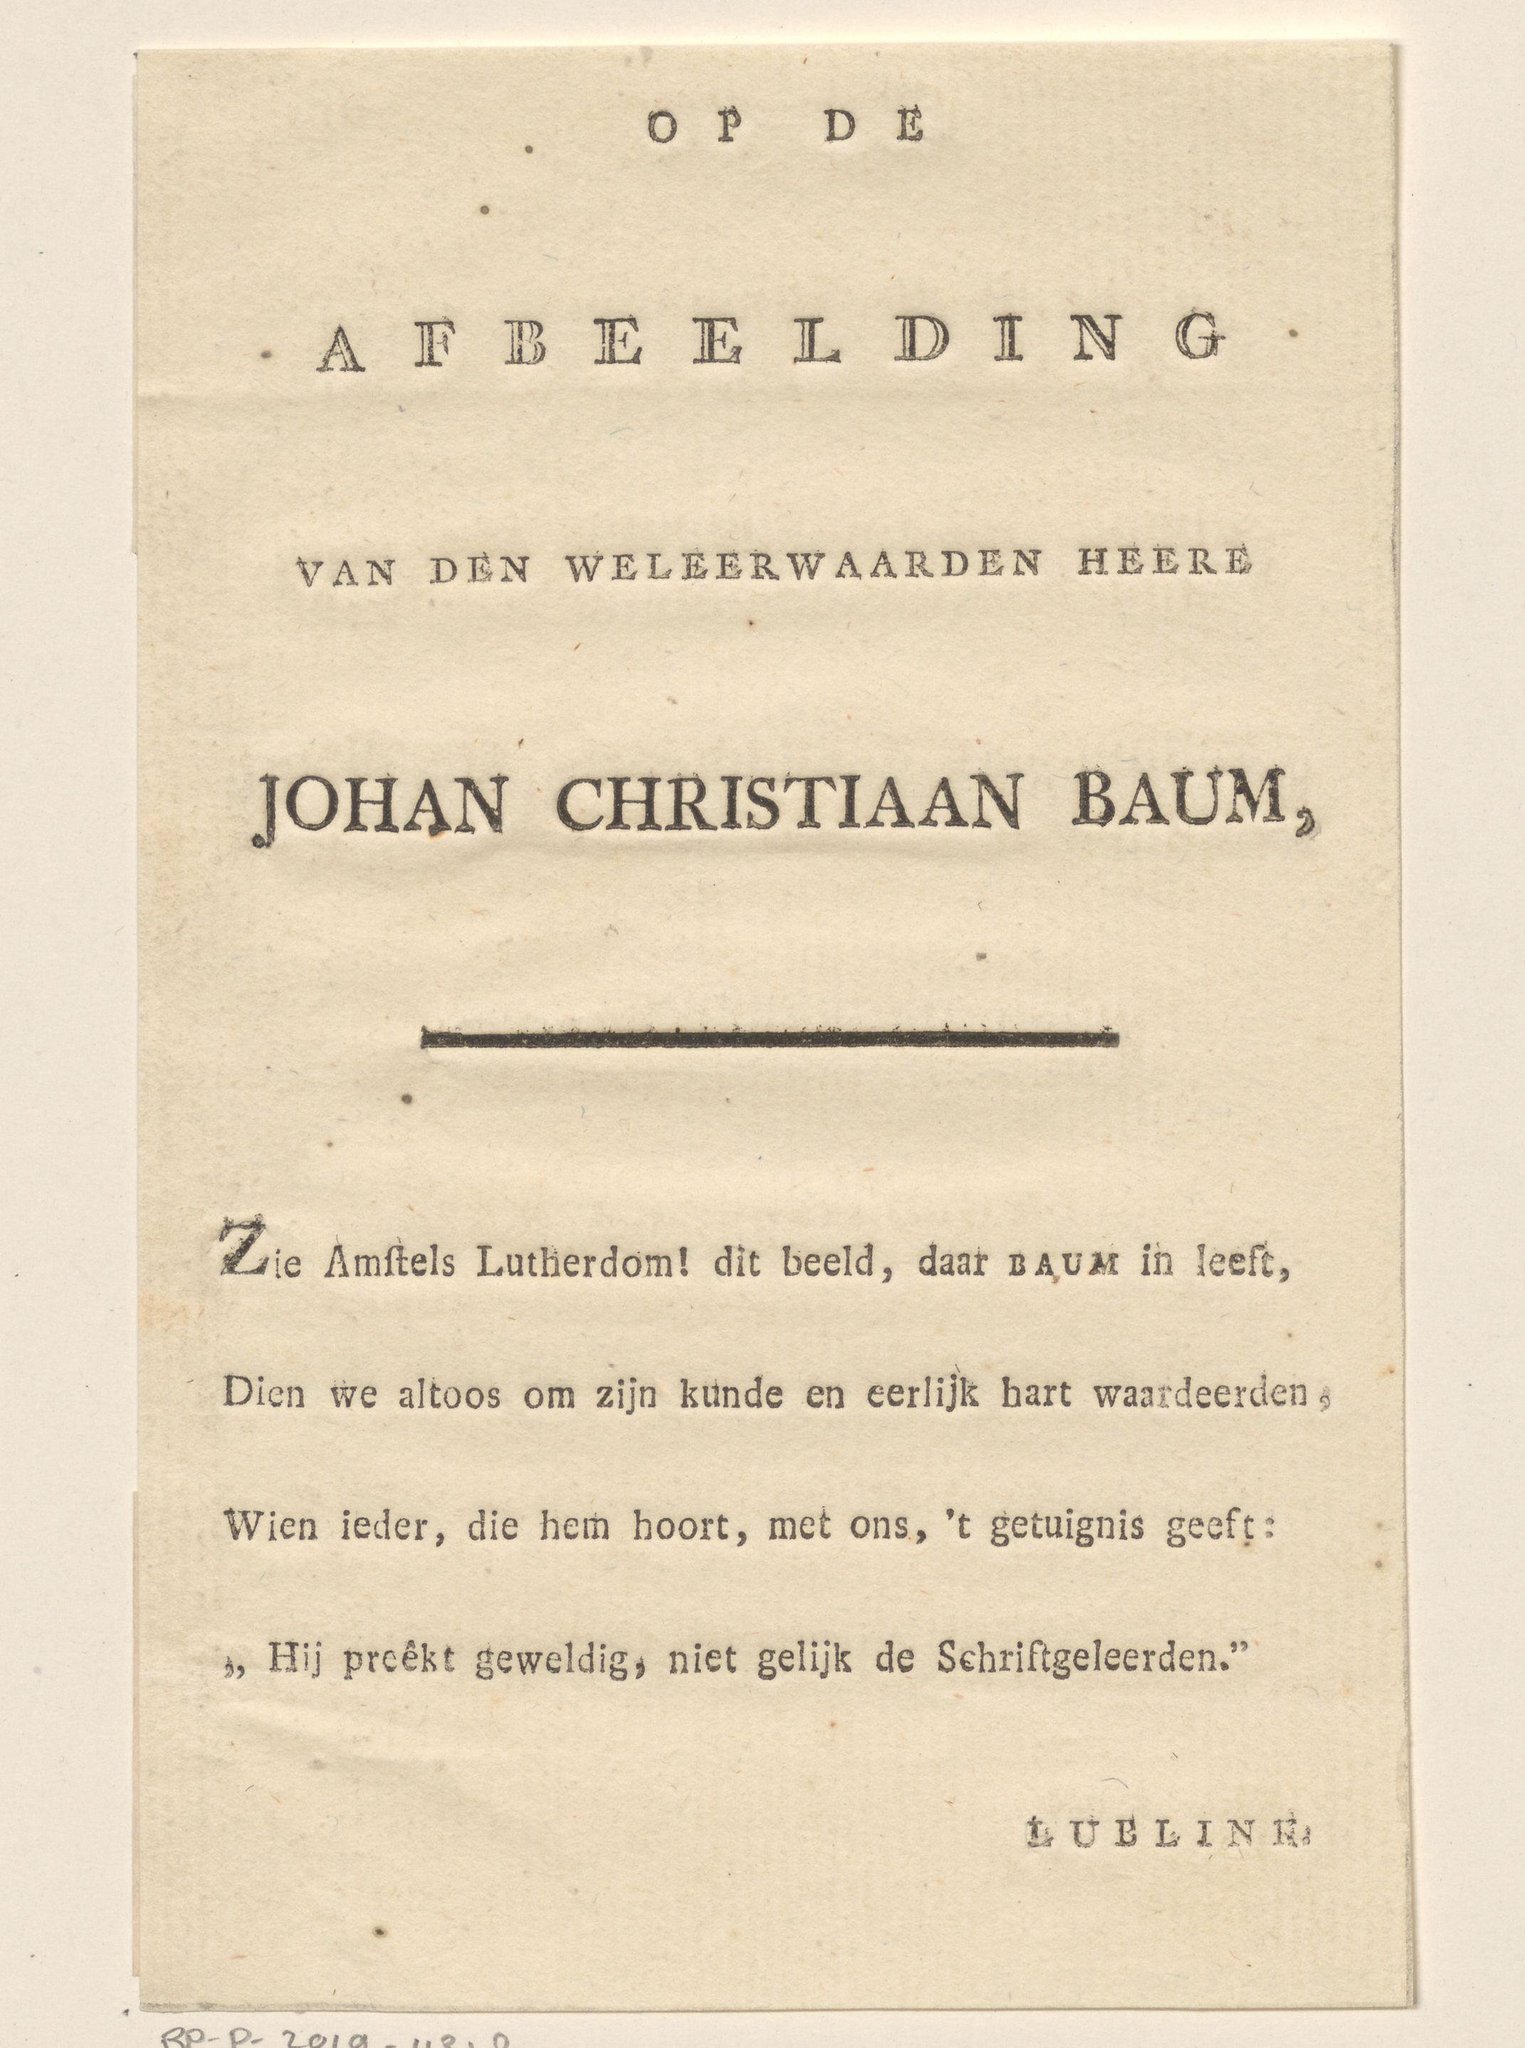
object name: poem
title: Vers op Johan Christiaan Baum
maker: johannes lublink (de jonge)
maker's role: schrijver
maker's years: 1736-1816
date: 1783-1820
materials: paper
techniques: letterpress printing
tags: germany, amsterdam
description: Mogelijk werd dit vers uitgegeven samen met een prent met een portret van Johan Christiaan Baum.